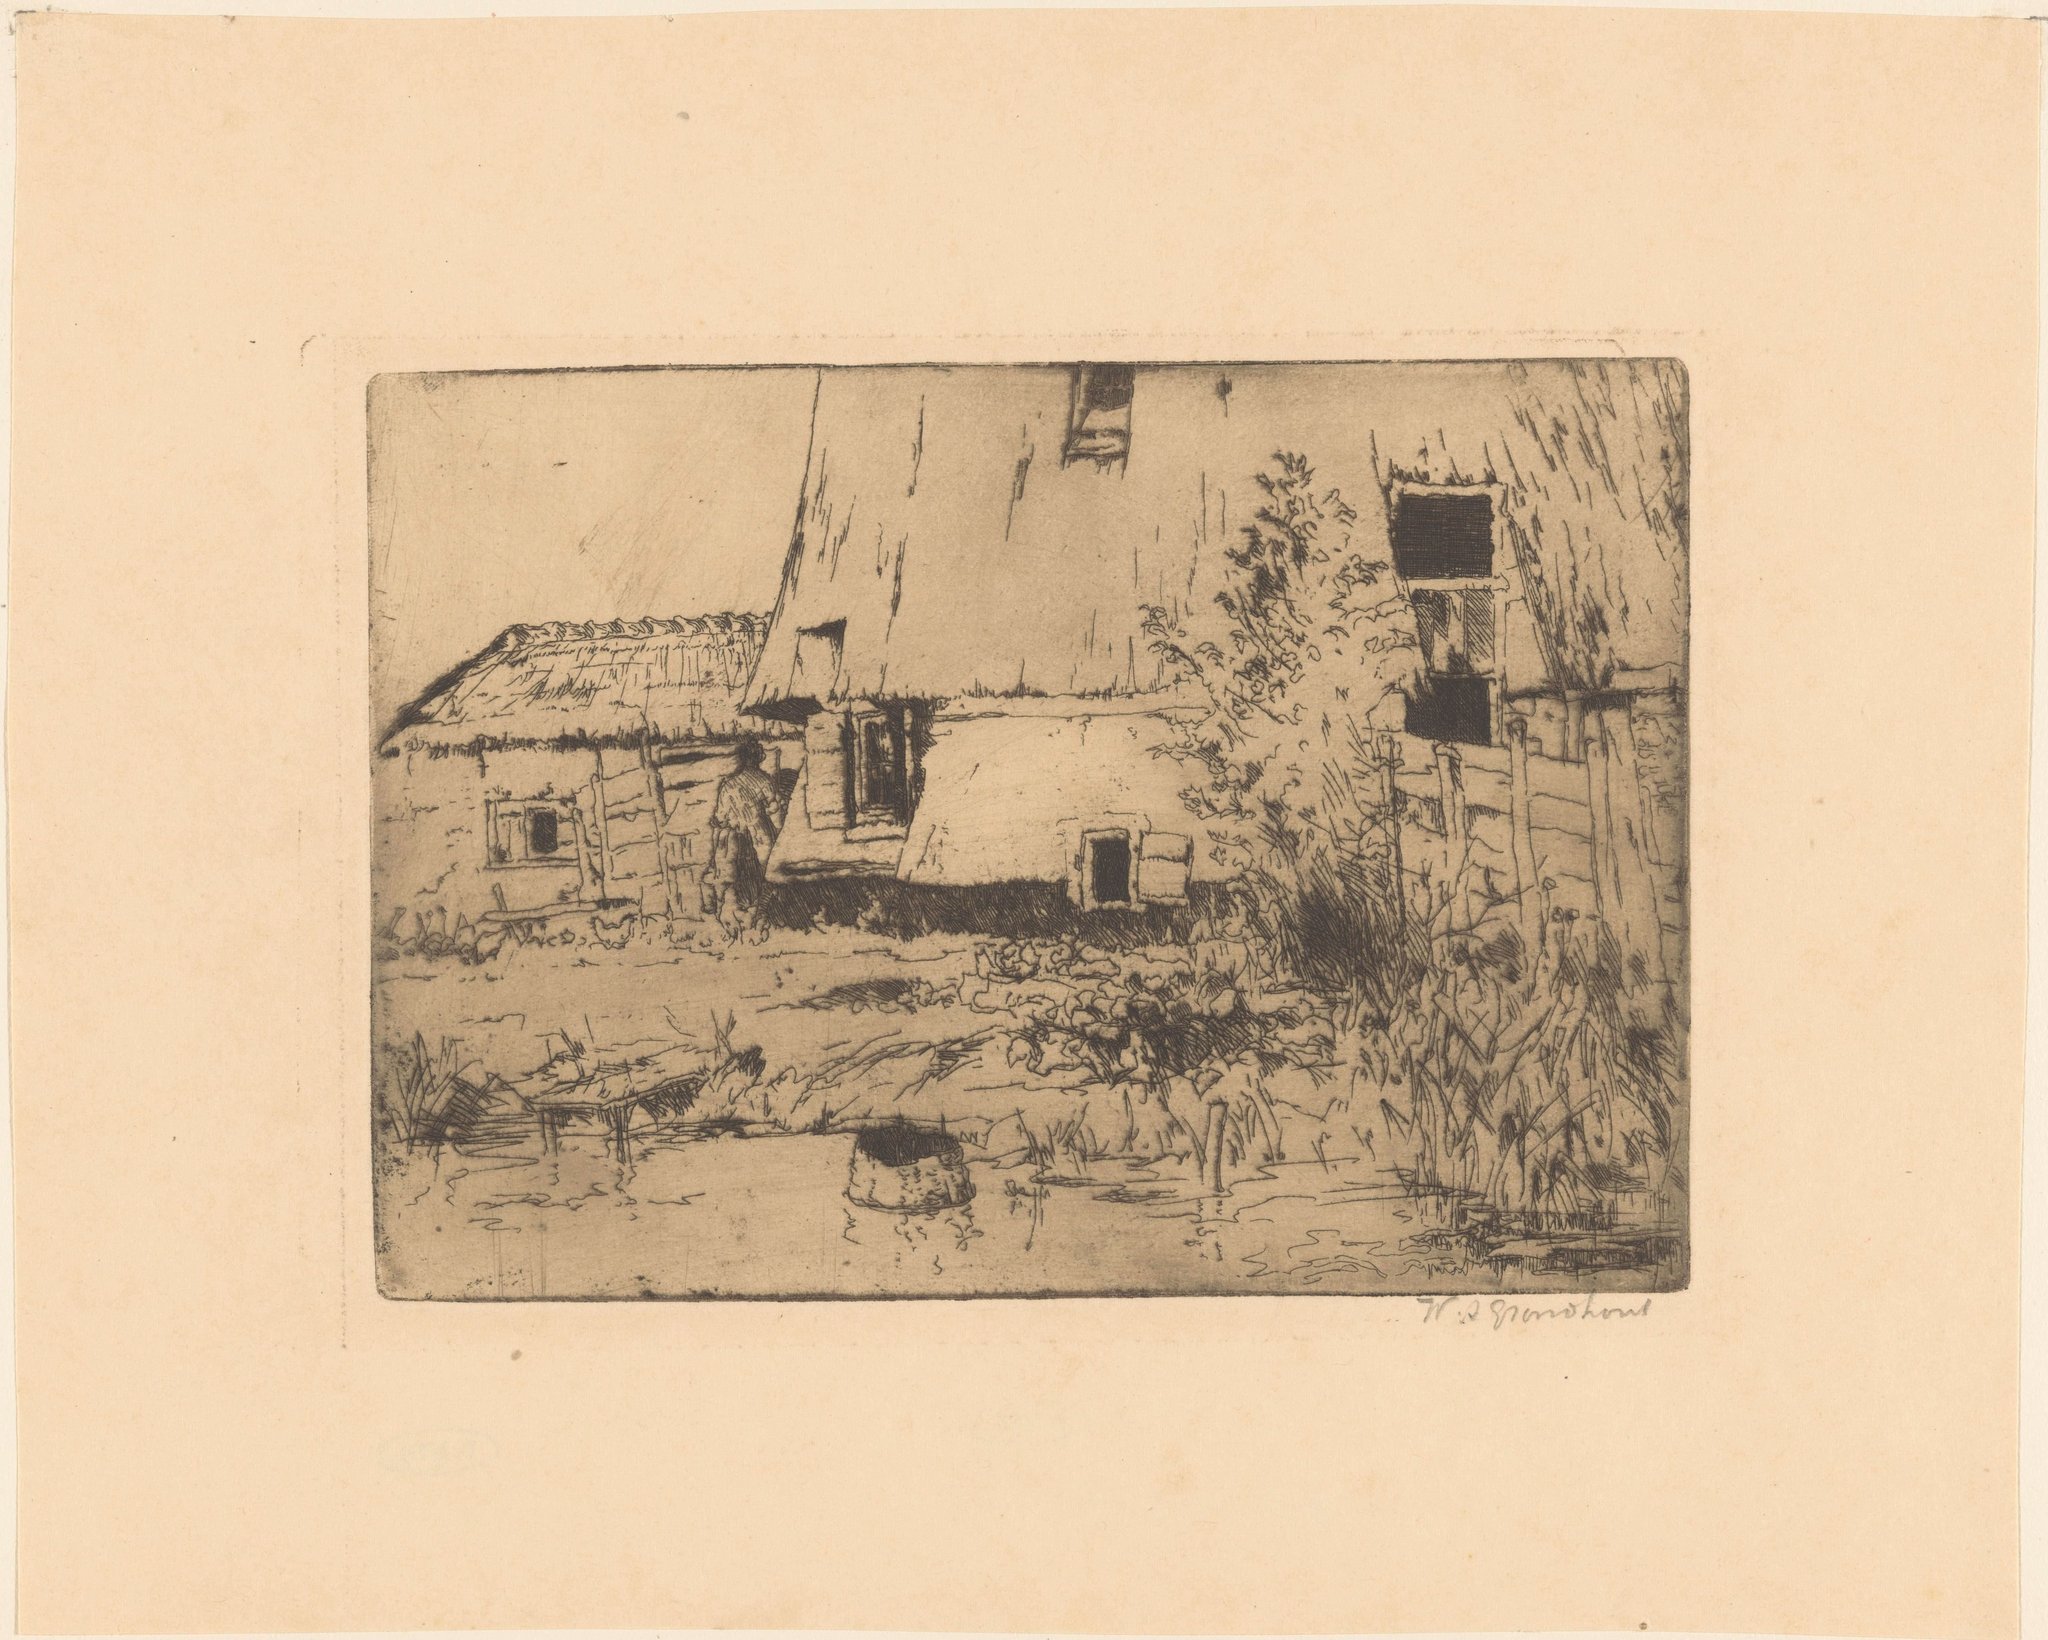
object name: print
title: Voet van een molen in Voorburg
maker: willem adrianus grondhout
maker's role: draughtsman, painter, print maker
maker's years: 1878-1934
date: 1888-1934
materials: paper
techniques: etching, intaglio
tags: windmill, voorburg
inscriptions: collector's mark: Lugt 2228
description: Op de voorgrond een aanlegsteiger op een oever.